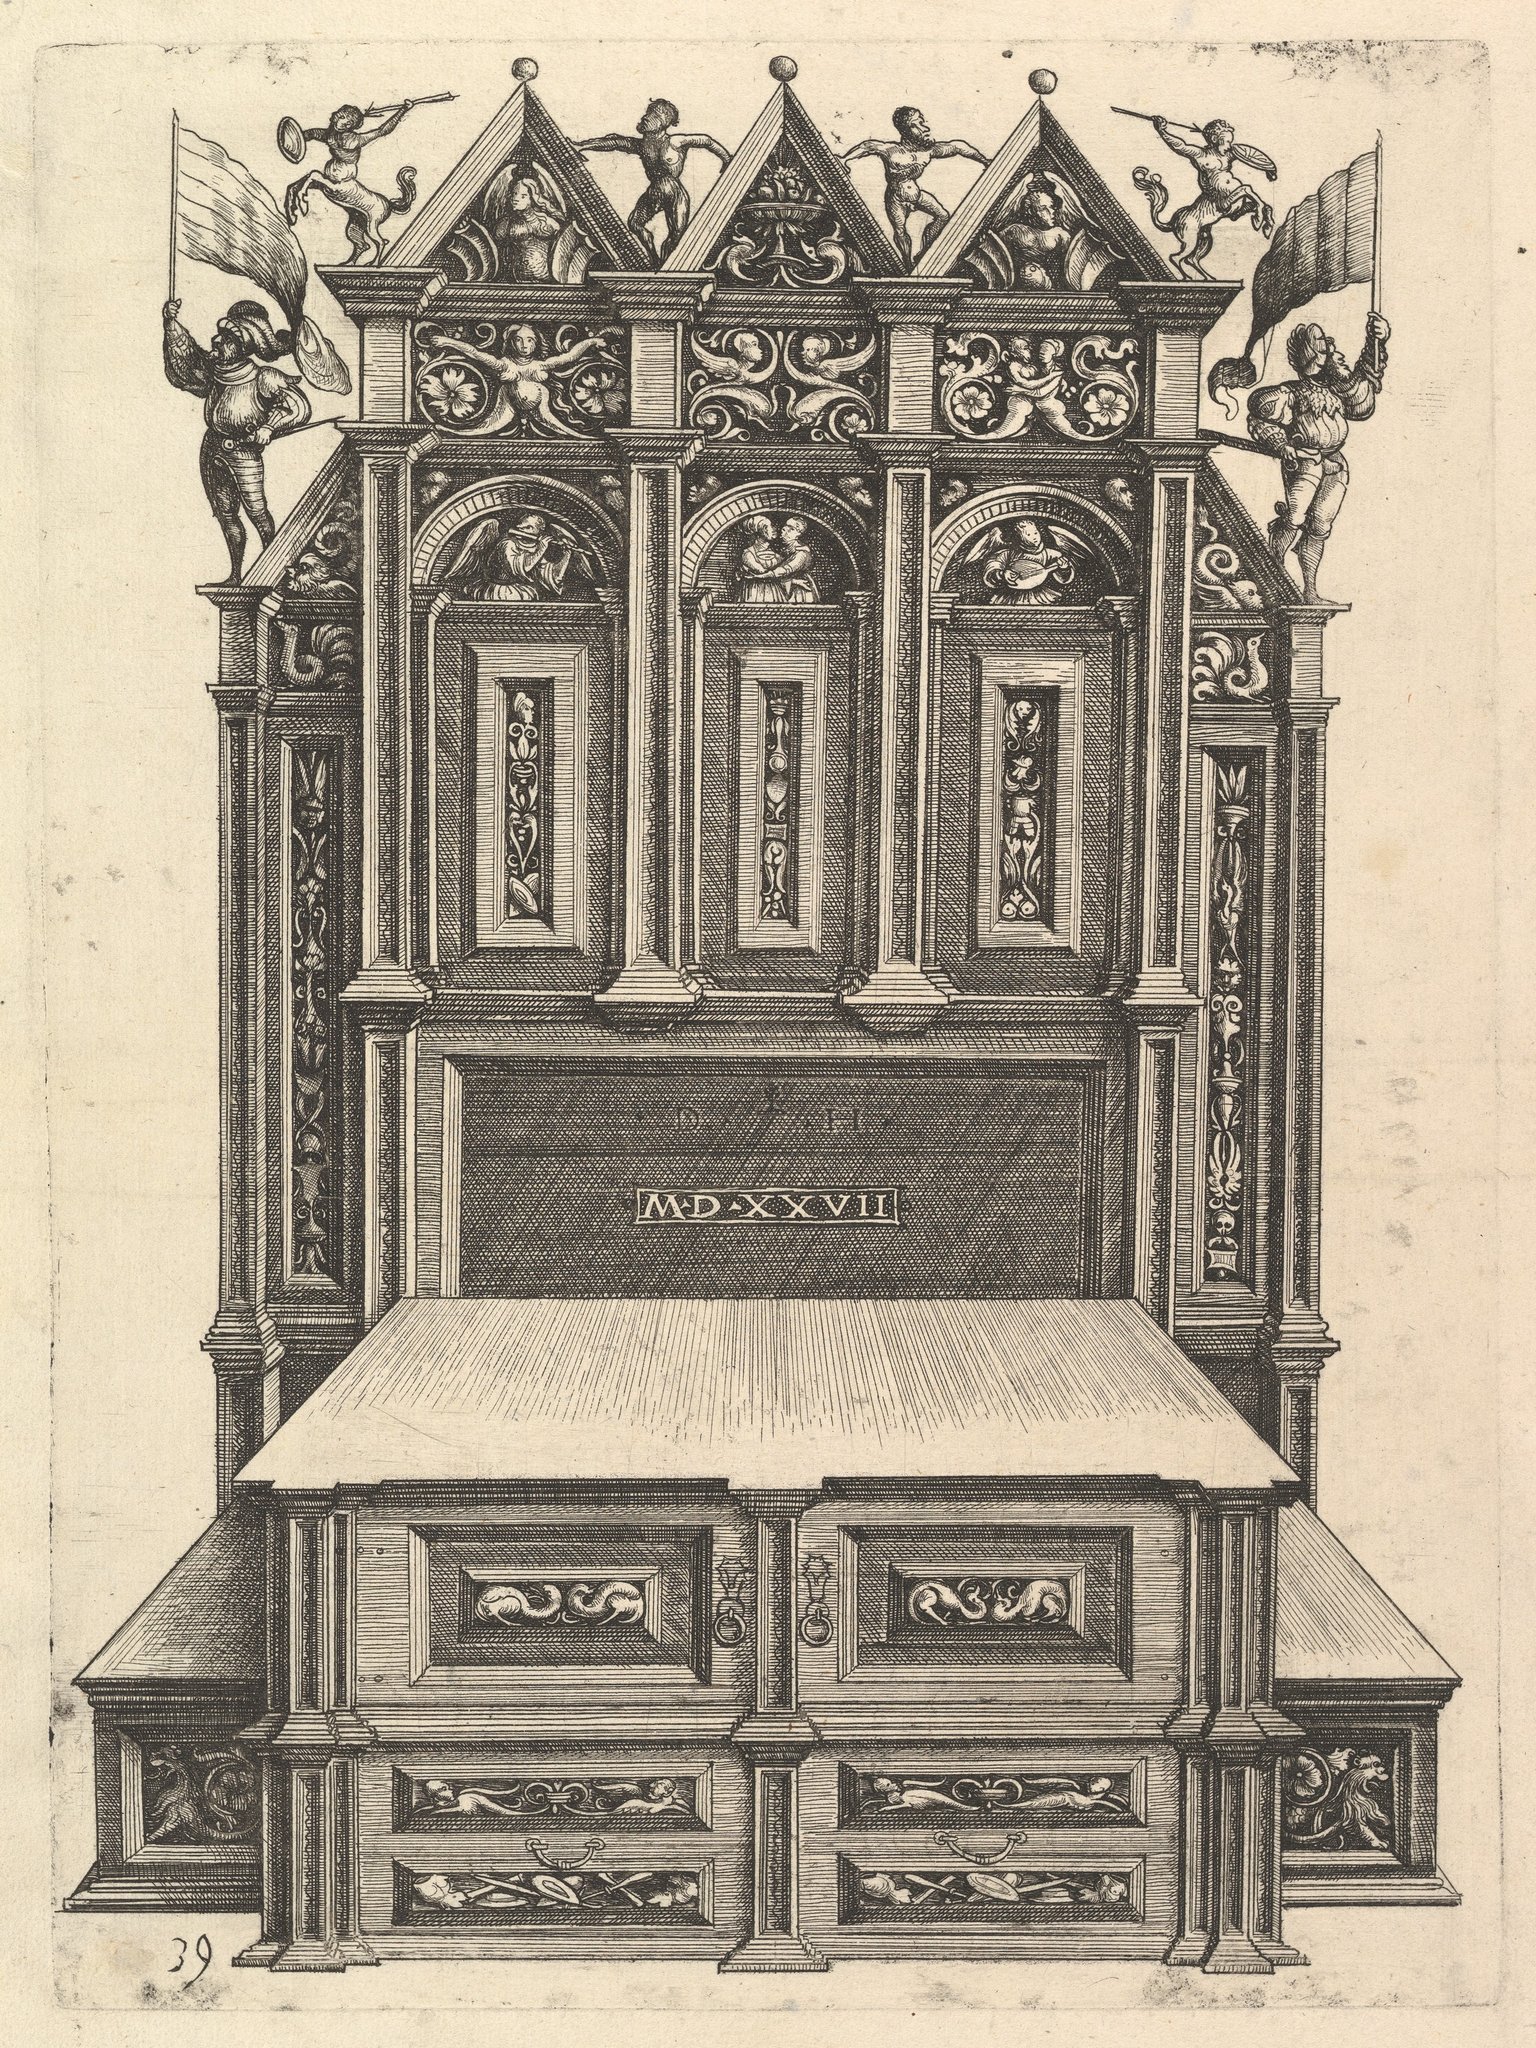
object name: print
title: Design for a bed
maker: daniel hopfer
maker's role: artist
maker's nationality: german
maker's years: 1470-1536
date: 1527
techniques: etching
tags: human figures,beds